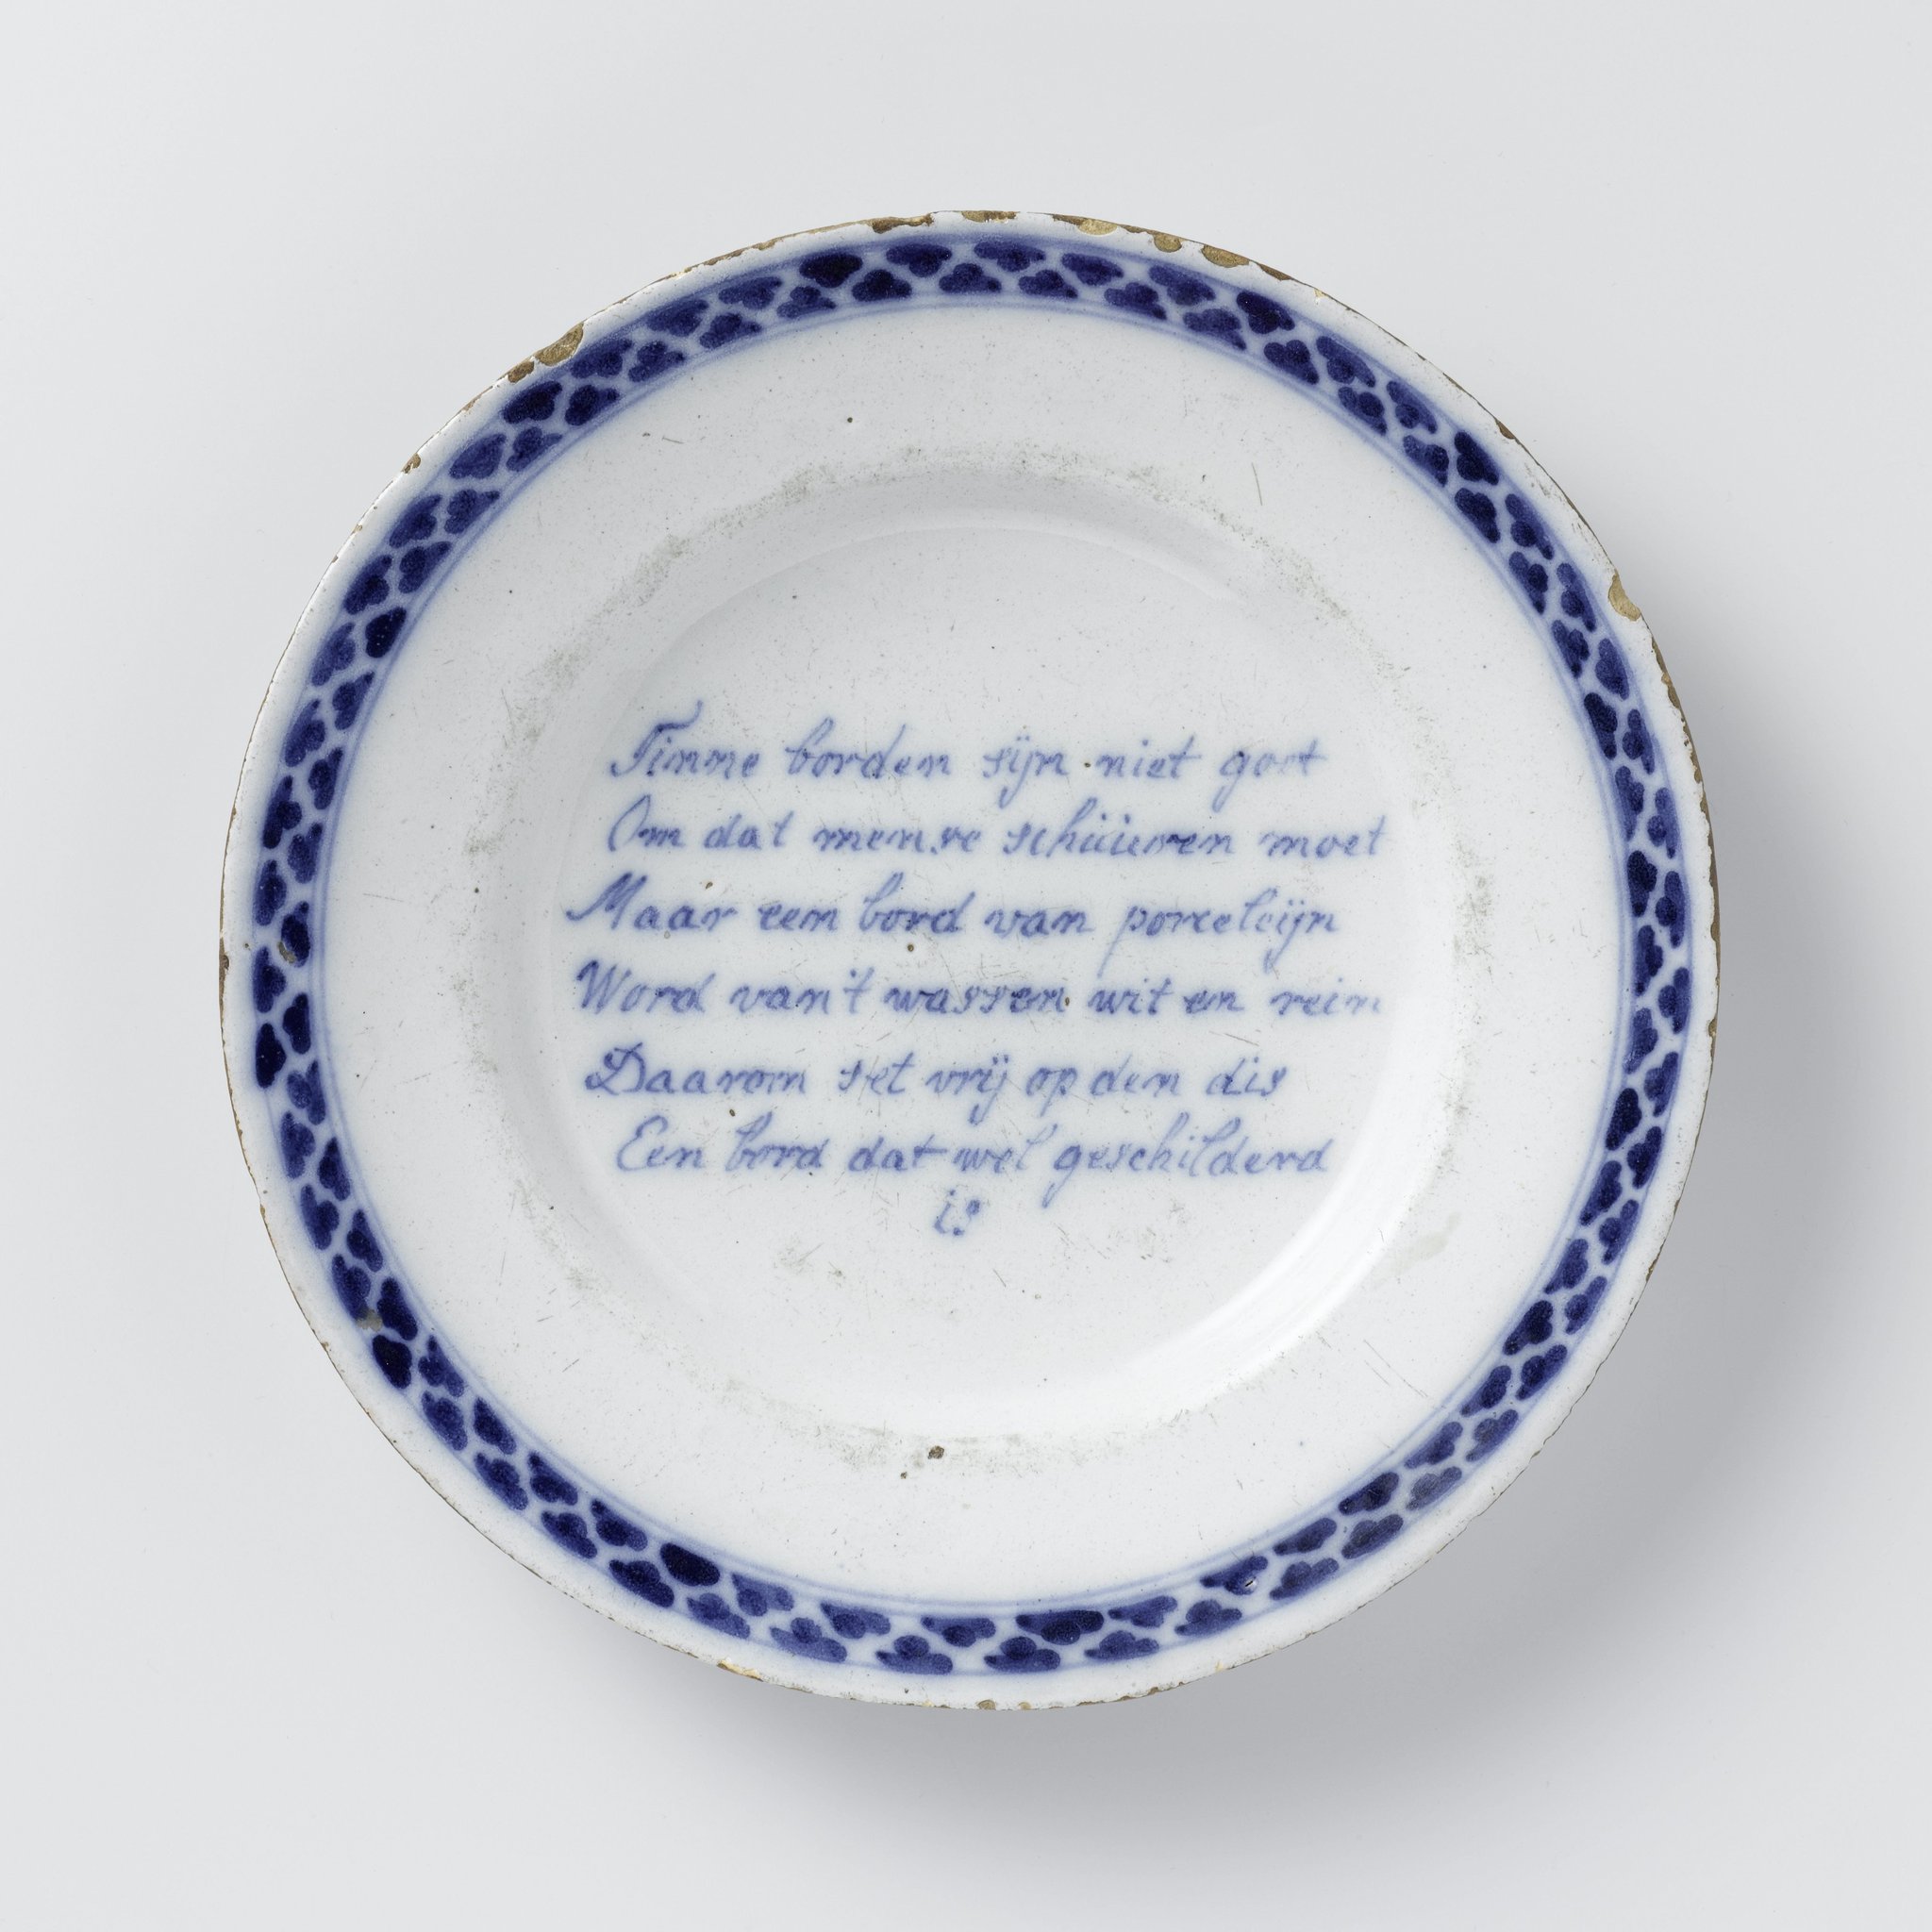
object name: plate dish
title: Bord, beschilderd met een versje: Tinne borden zijn niet goet // Om dat mense schuuren moet ... Een bord dat wel geschilderd // is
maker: Anonymous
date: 1740-1755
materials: faience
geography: delft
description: Bord van faience. Blauw beschilderd met een versje en een gedecoreerde rand. Het versje luidt: Tinne borden zijn niet goet // Om dat mense schuuren moet // Maar een bord van porcelijn // Word van 't wassen wit en rein // Daarom set vrij op den dis // Een bord dat wel geschilderd // is.